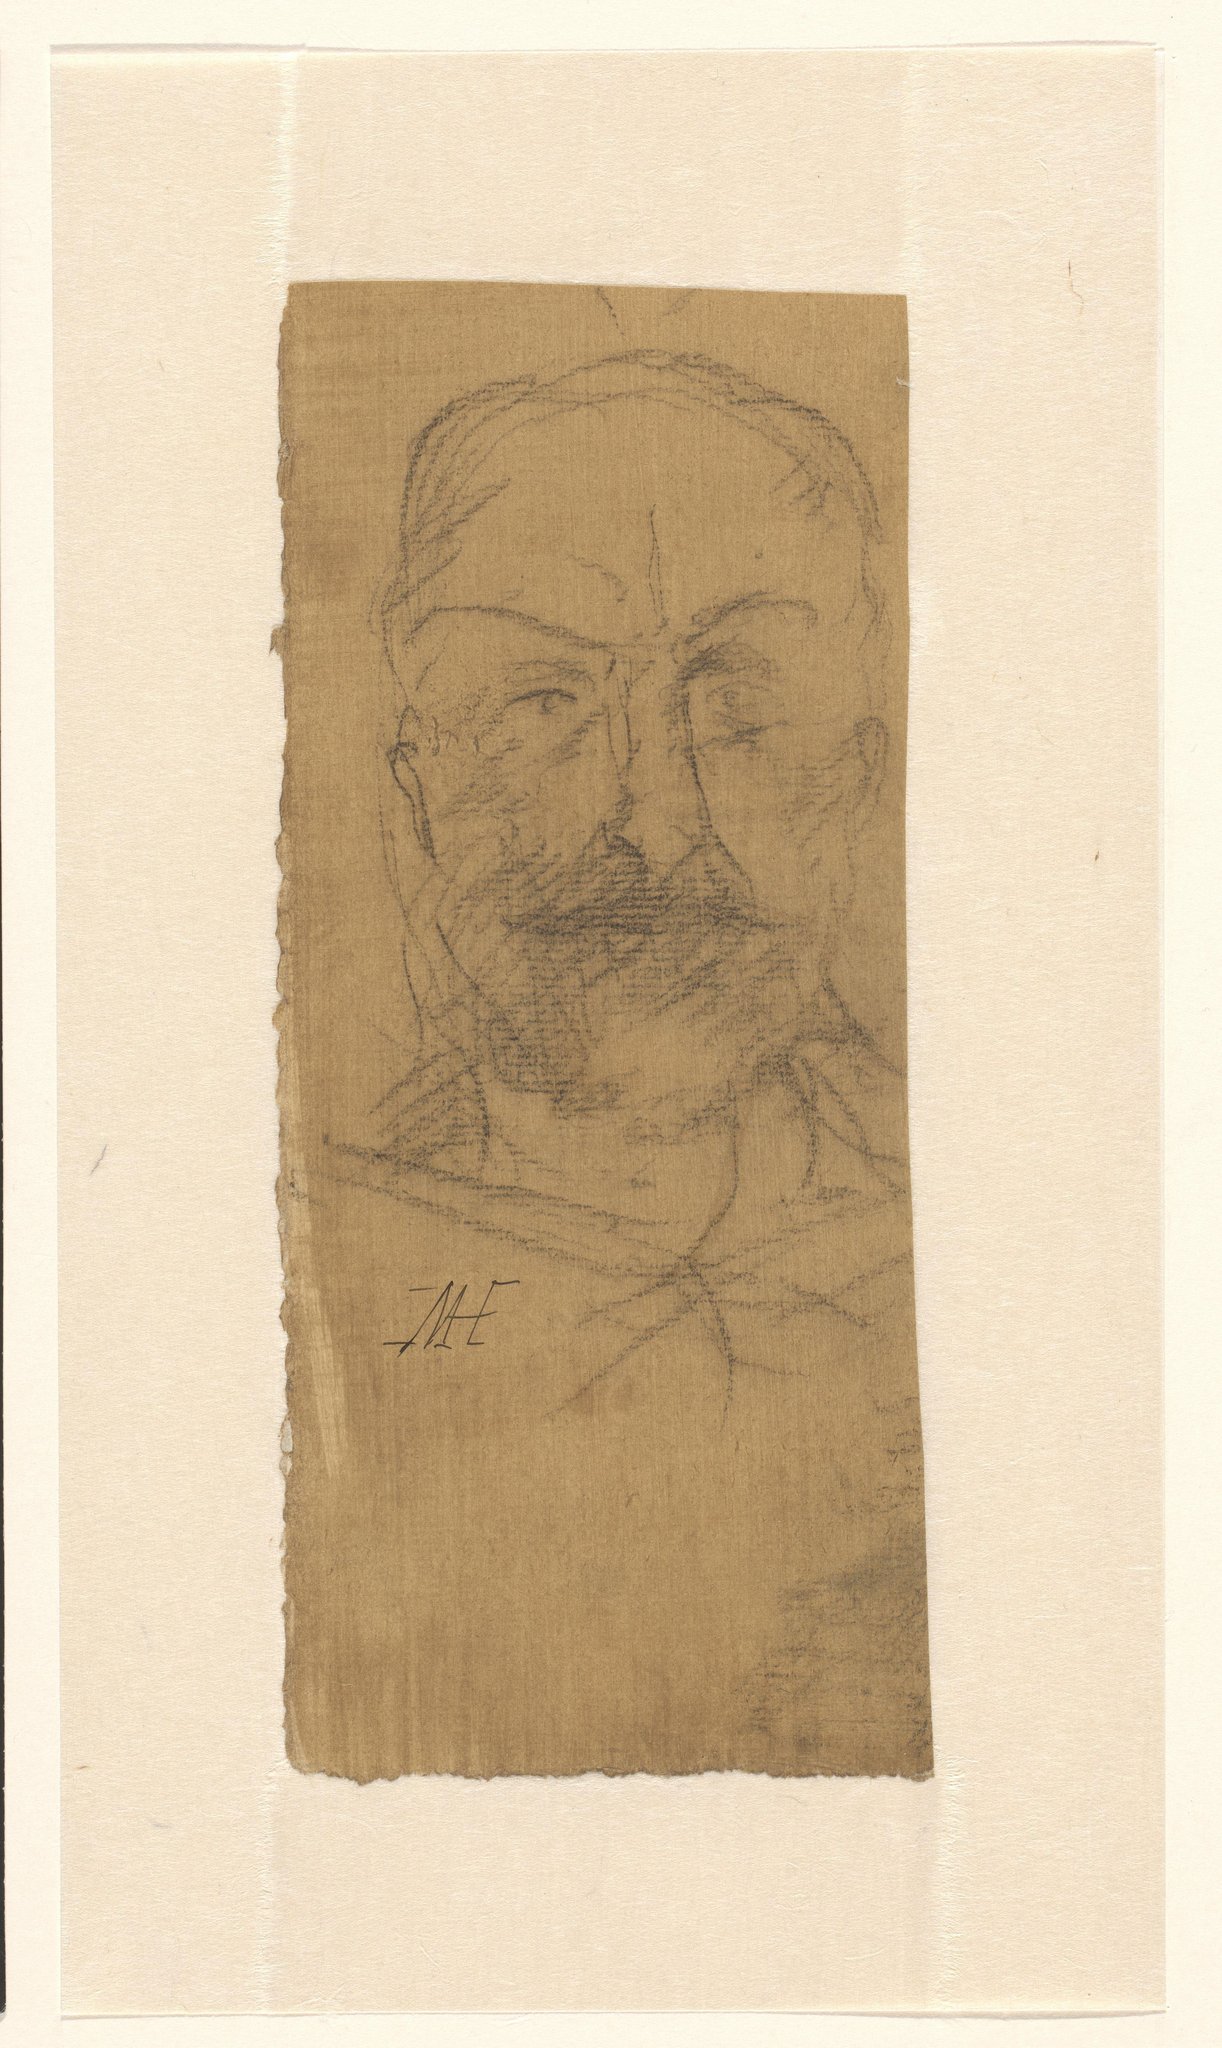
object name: drawing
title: Kop van een man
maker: marius holleman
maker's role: draughtsman, print maker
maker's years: 1878-1926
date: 1888-1926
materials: chalk, paper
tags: head (human)